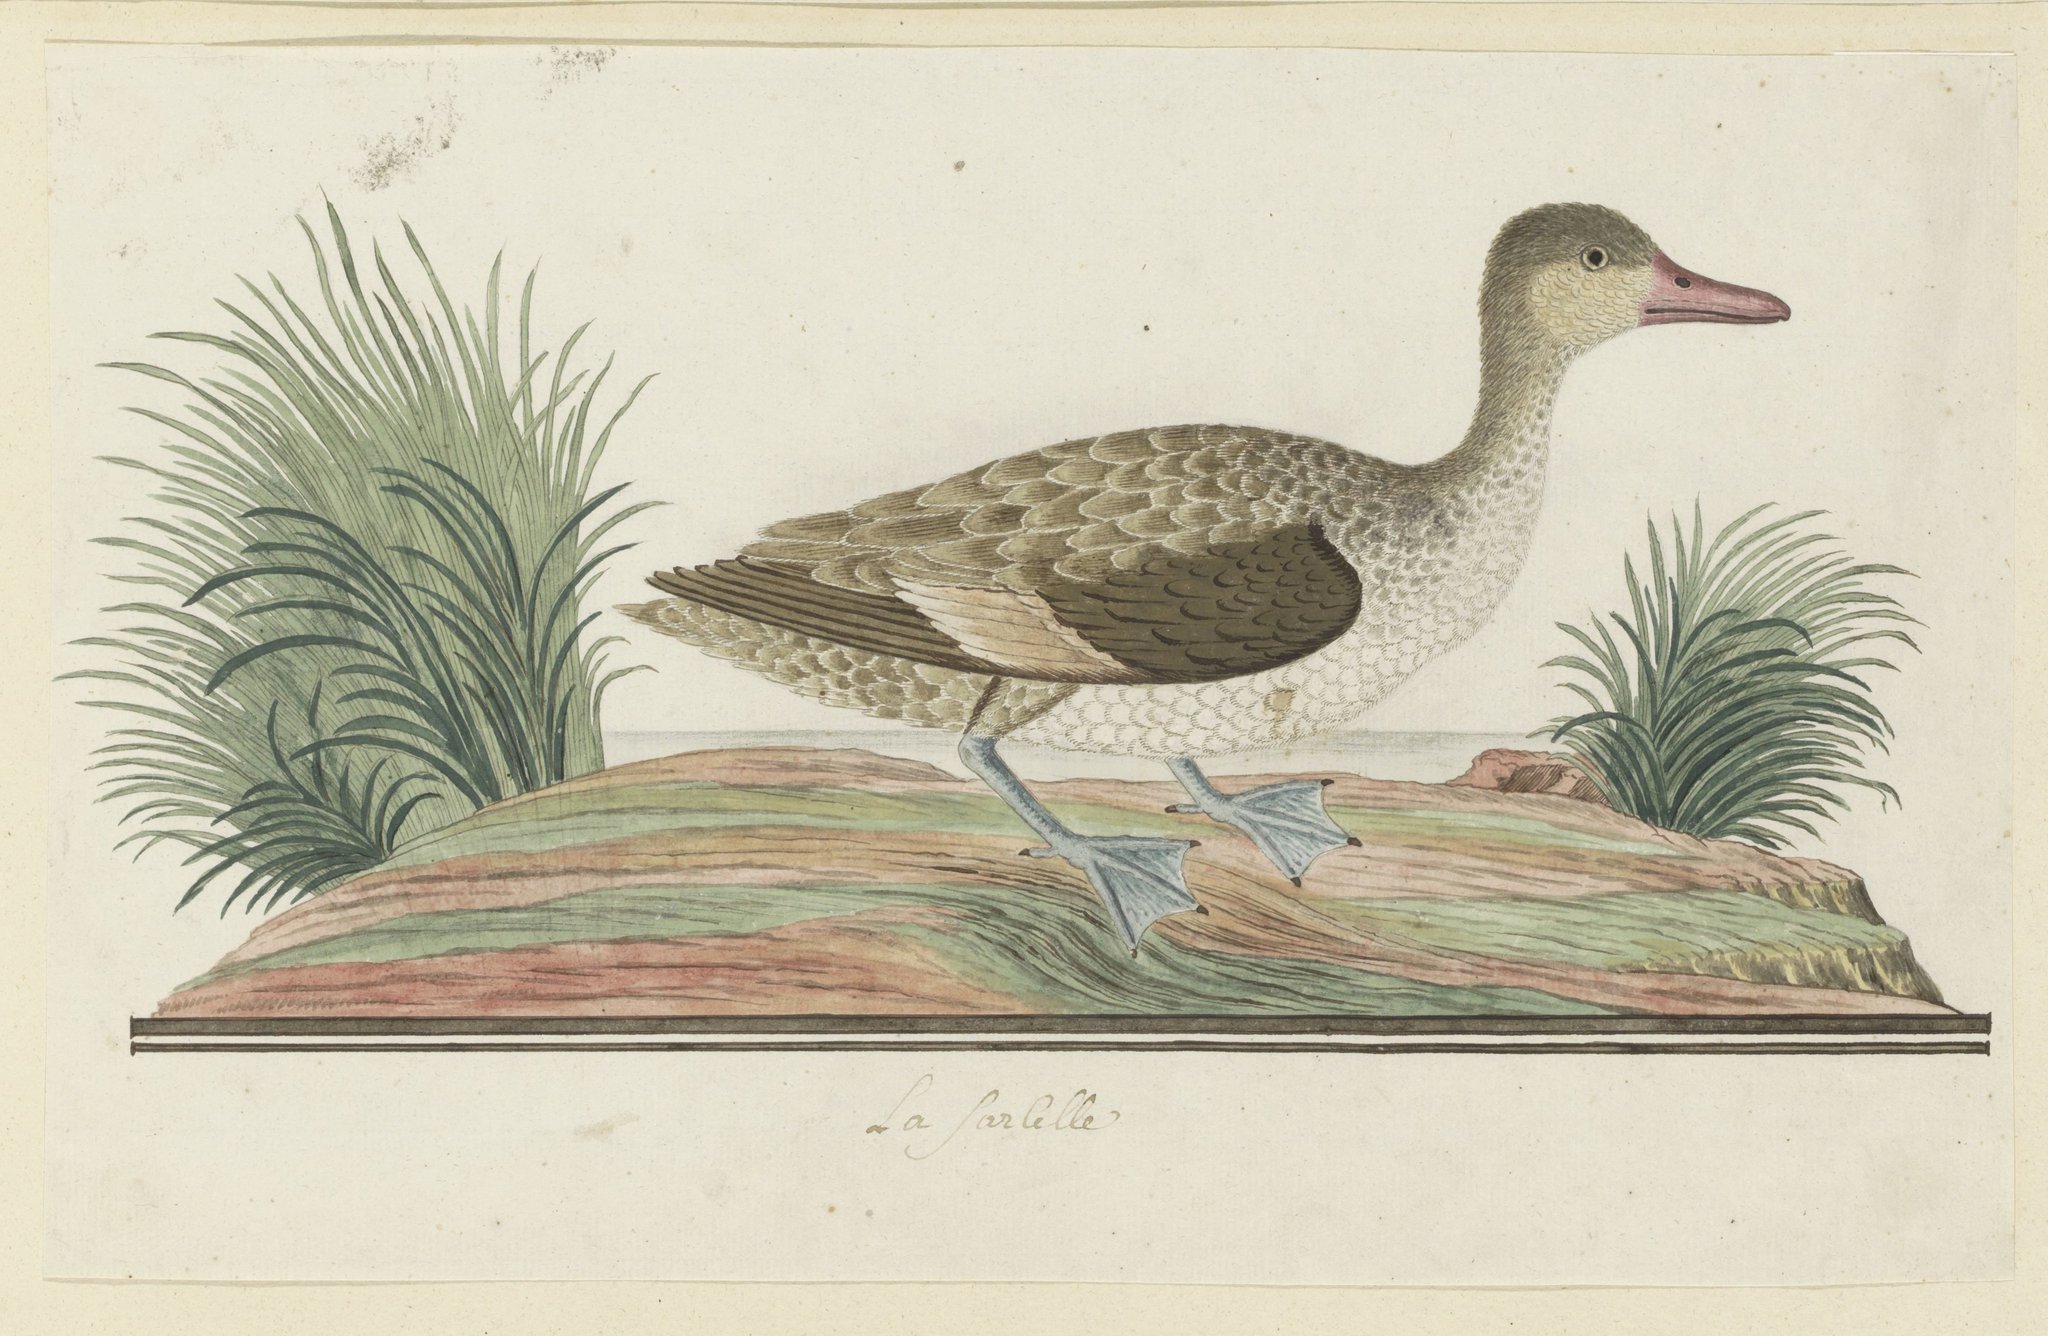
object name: album leaf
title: Anas erythrorhyncha (Red-billed teal)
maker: robert jacob gordon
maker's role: draughtsman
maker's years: 1743-1795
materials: chalk, ink, paper, pencil, watercolor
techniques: brush, pen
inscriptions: annotation: ‘La sarcelle’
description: Red bill teal (Eng.). Franse benaming geschreven door Levaillant.